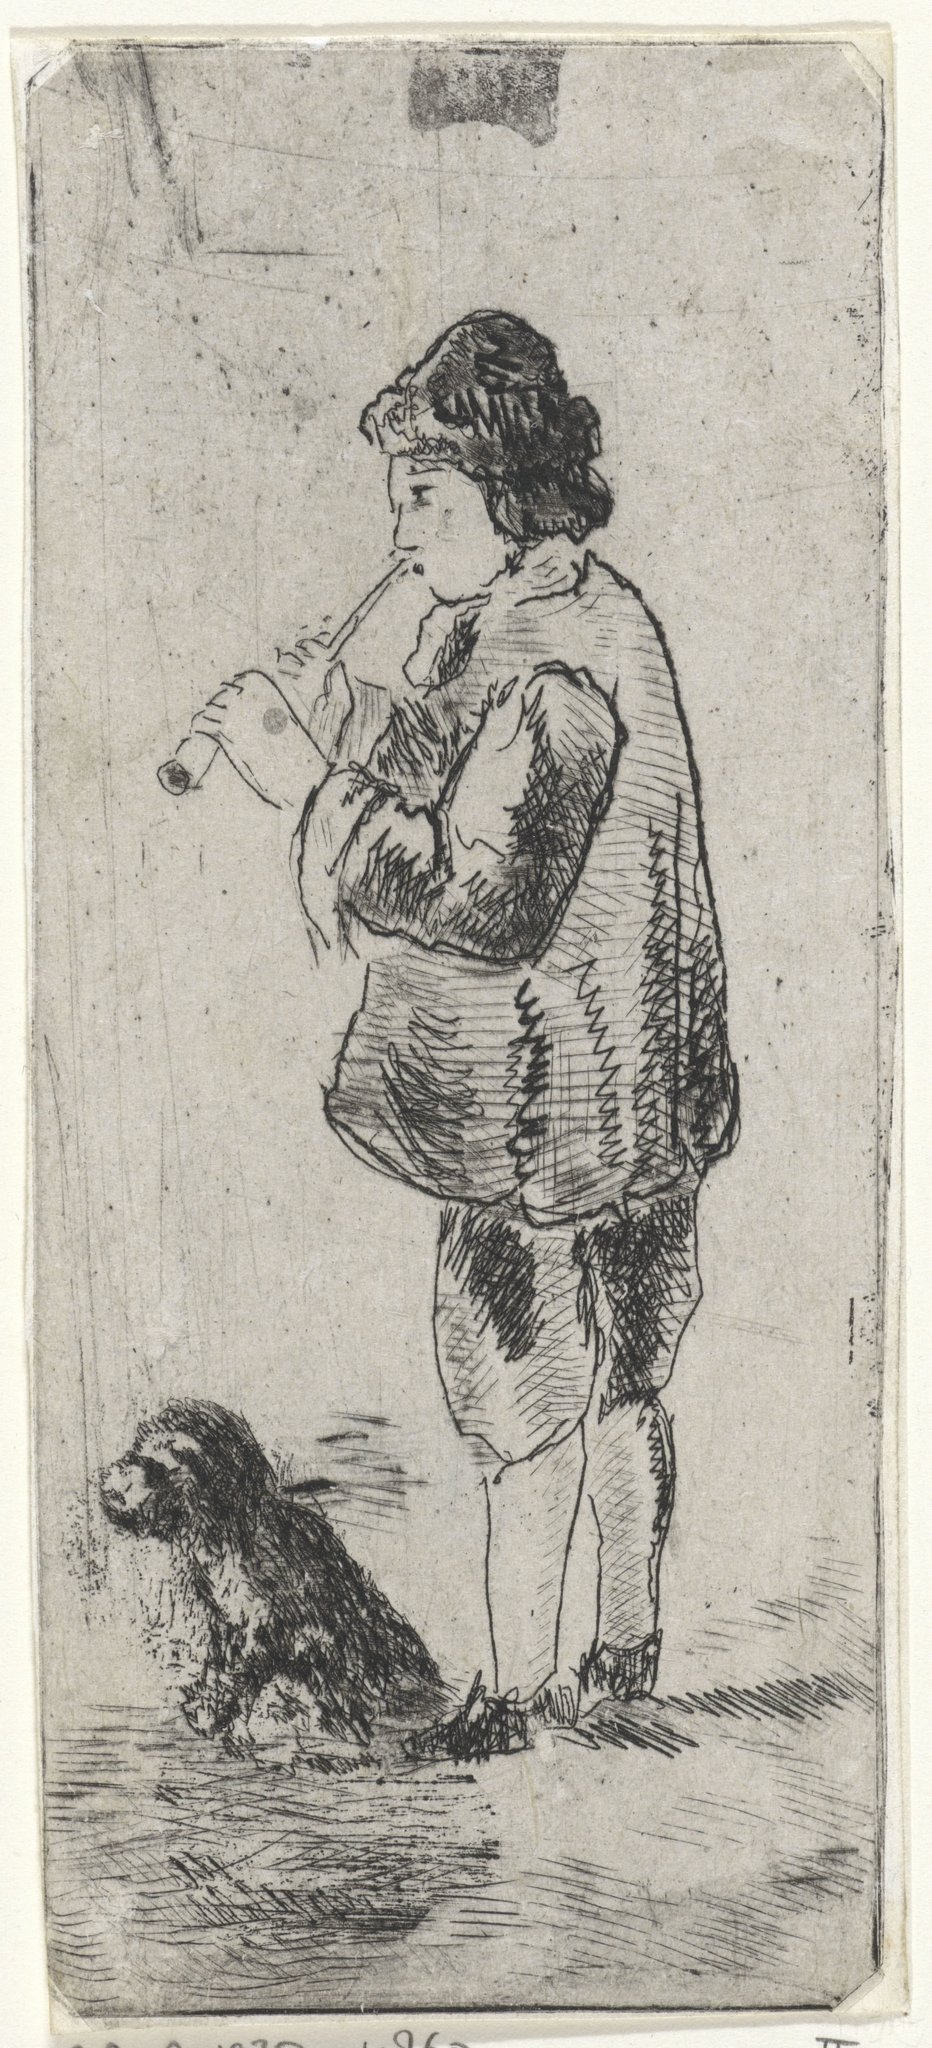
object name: print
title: Fluitspelende jongen met hond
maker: arnoud schaepkens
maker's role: print maker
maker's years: 1816-1904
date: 1831-1904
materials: paper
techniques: drypoint, etching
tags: youth, adolescent, flute, aulos, tibia, dog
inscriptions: collector's mark: Lugt 2228